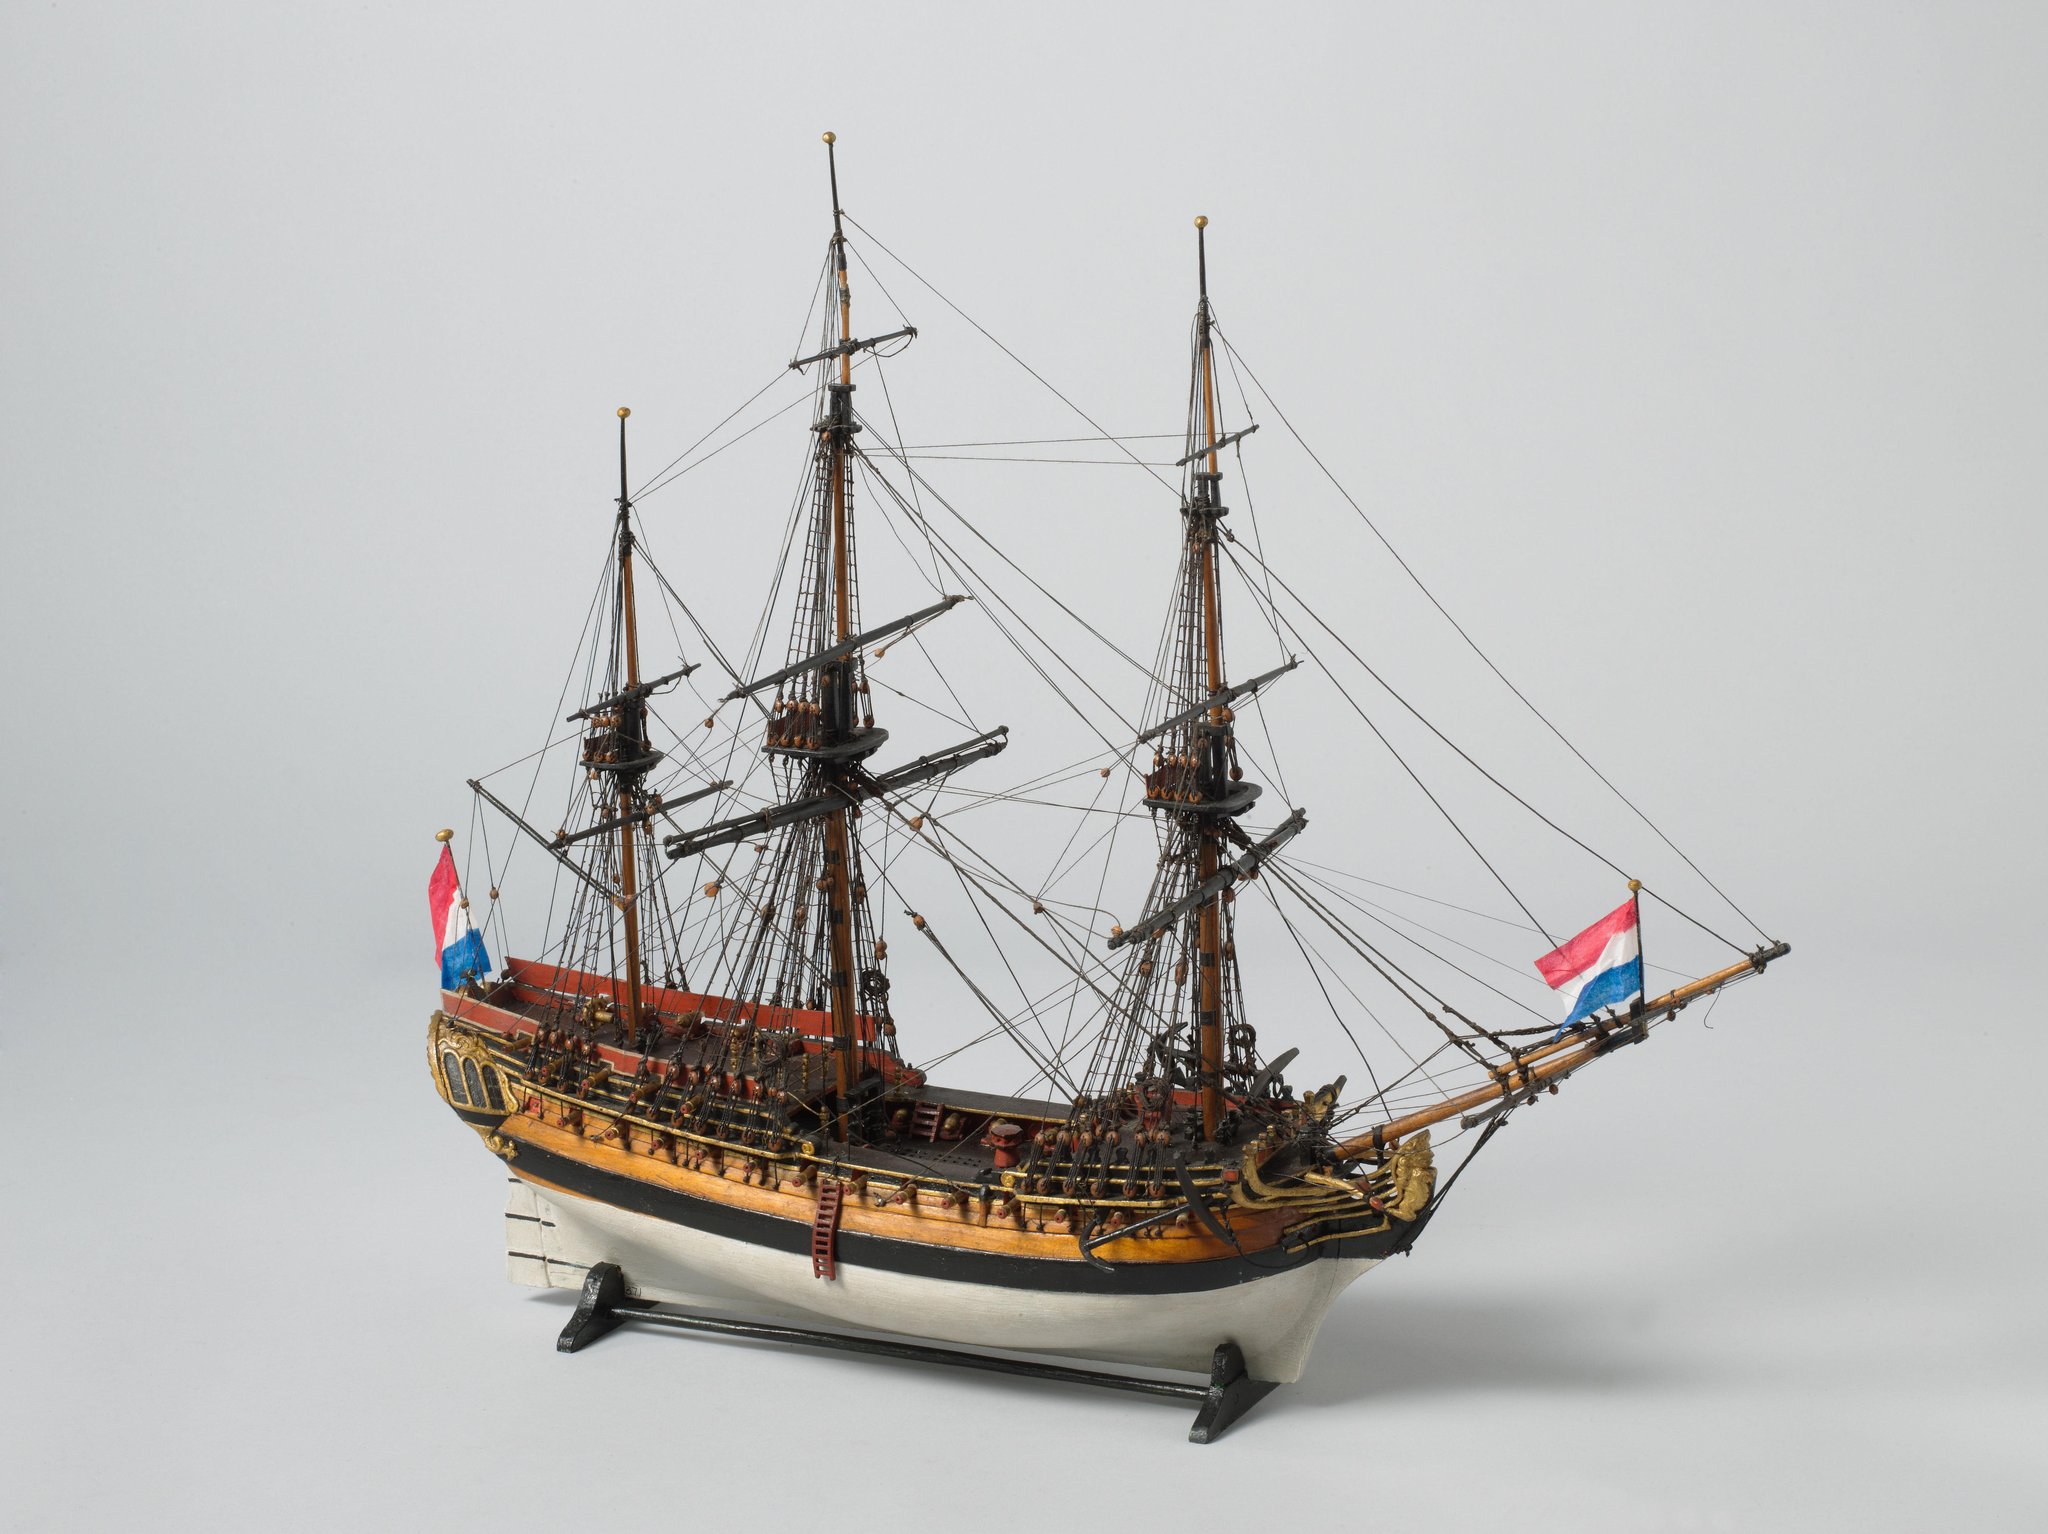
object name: ship model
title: Model of a 38-Gun Frigate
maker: Anonymous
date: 1780-1830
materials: brass, paper, fiber, silk, wood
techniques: polychromy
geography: netherlands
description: Voor zover bekend stelt het geen specifiek schip voor.